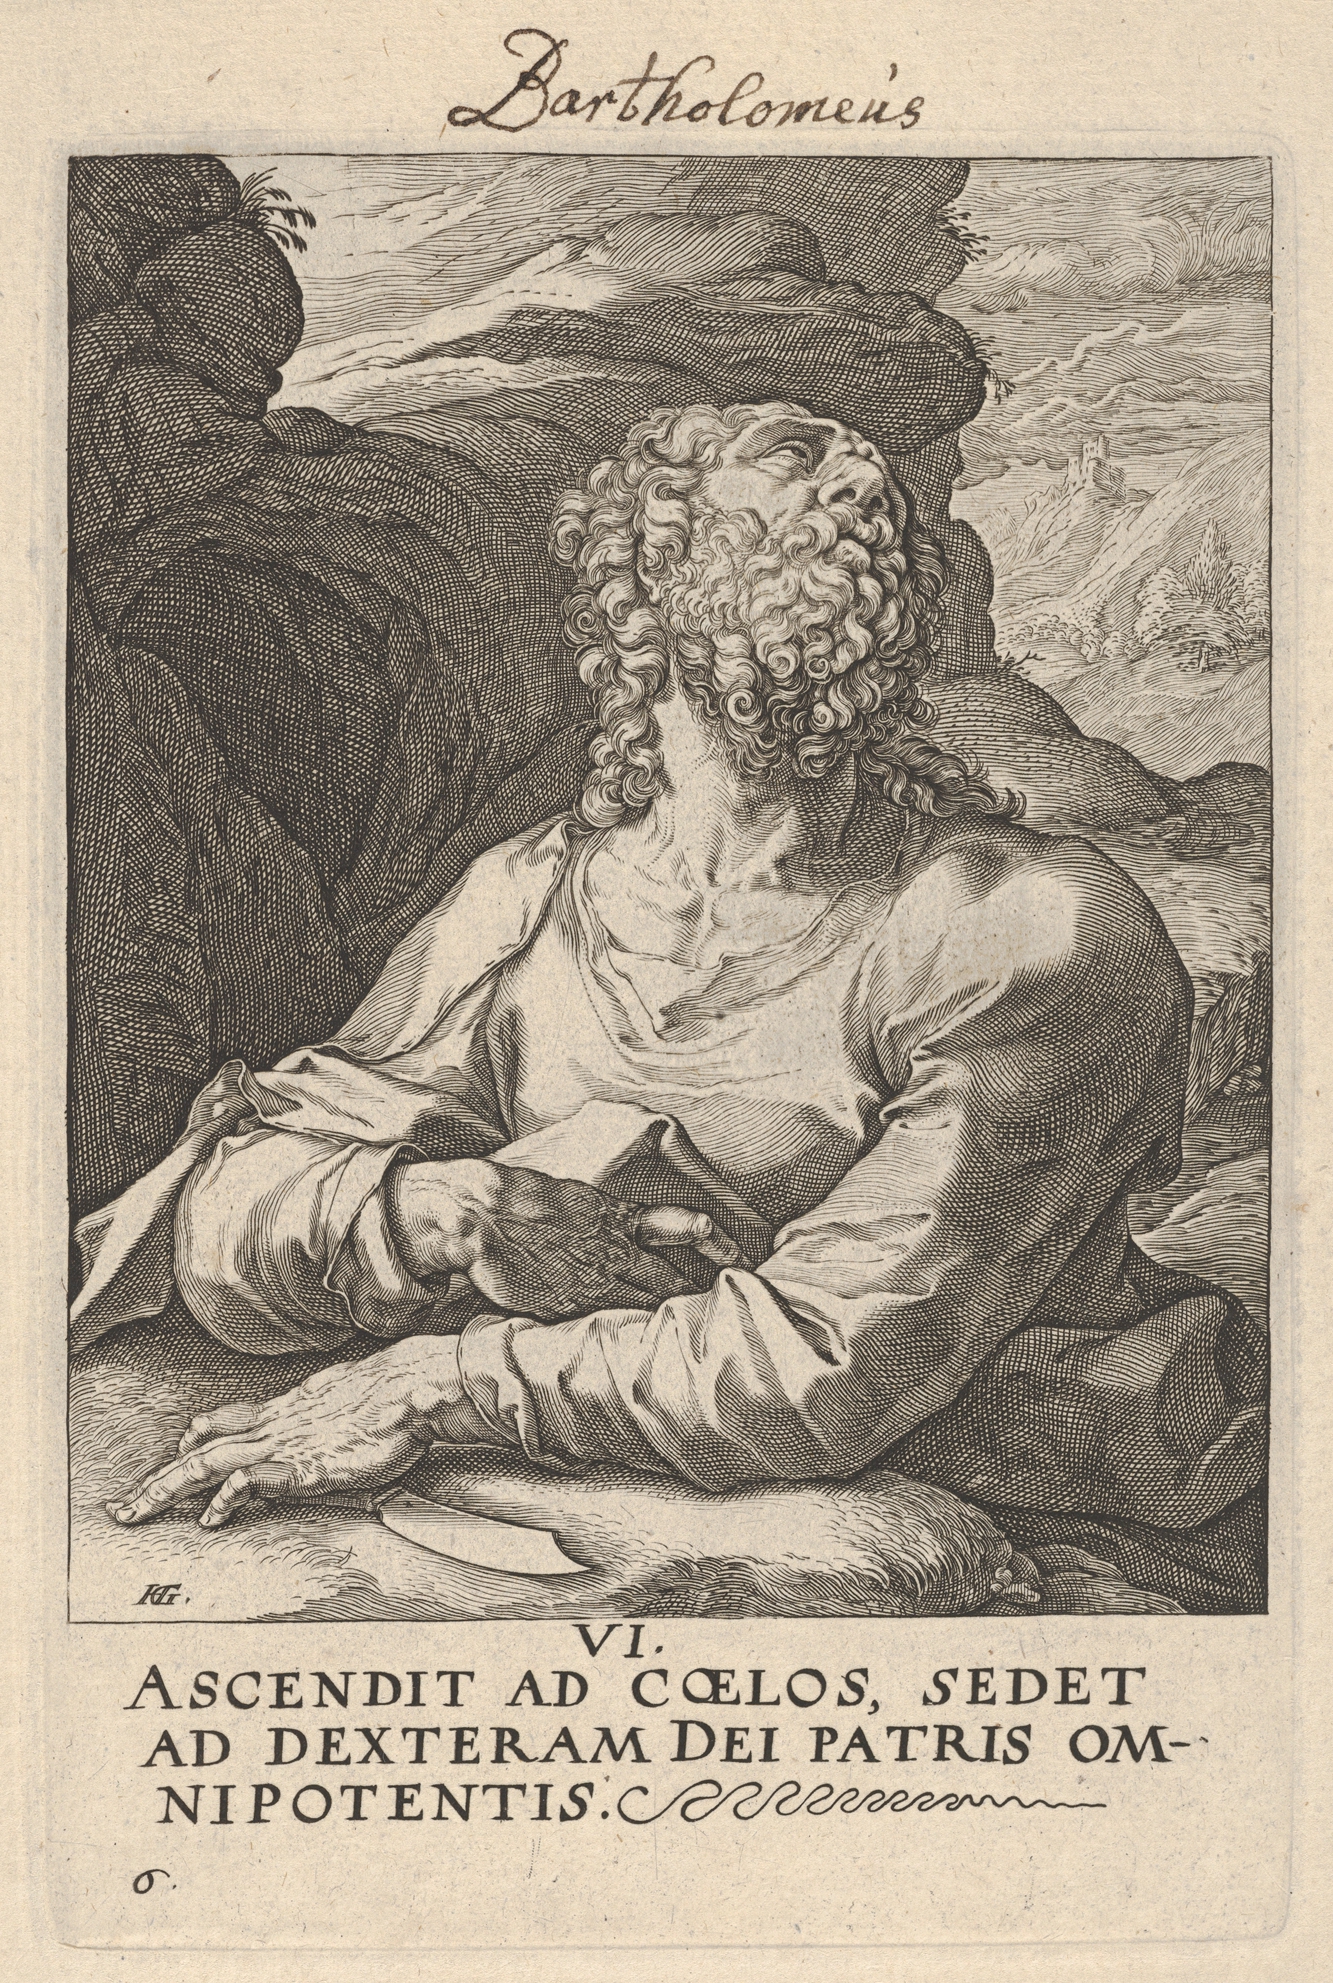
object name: print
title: St. Bartholomew, from "Christ, the Apostles and St. Paul with the Creed"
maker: hendrick goltzius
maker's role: artist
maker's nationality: netherlandish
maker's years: 1558-1617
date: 1589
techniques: engraving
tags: saints